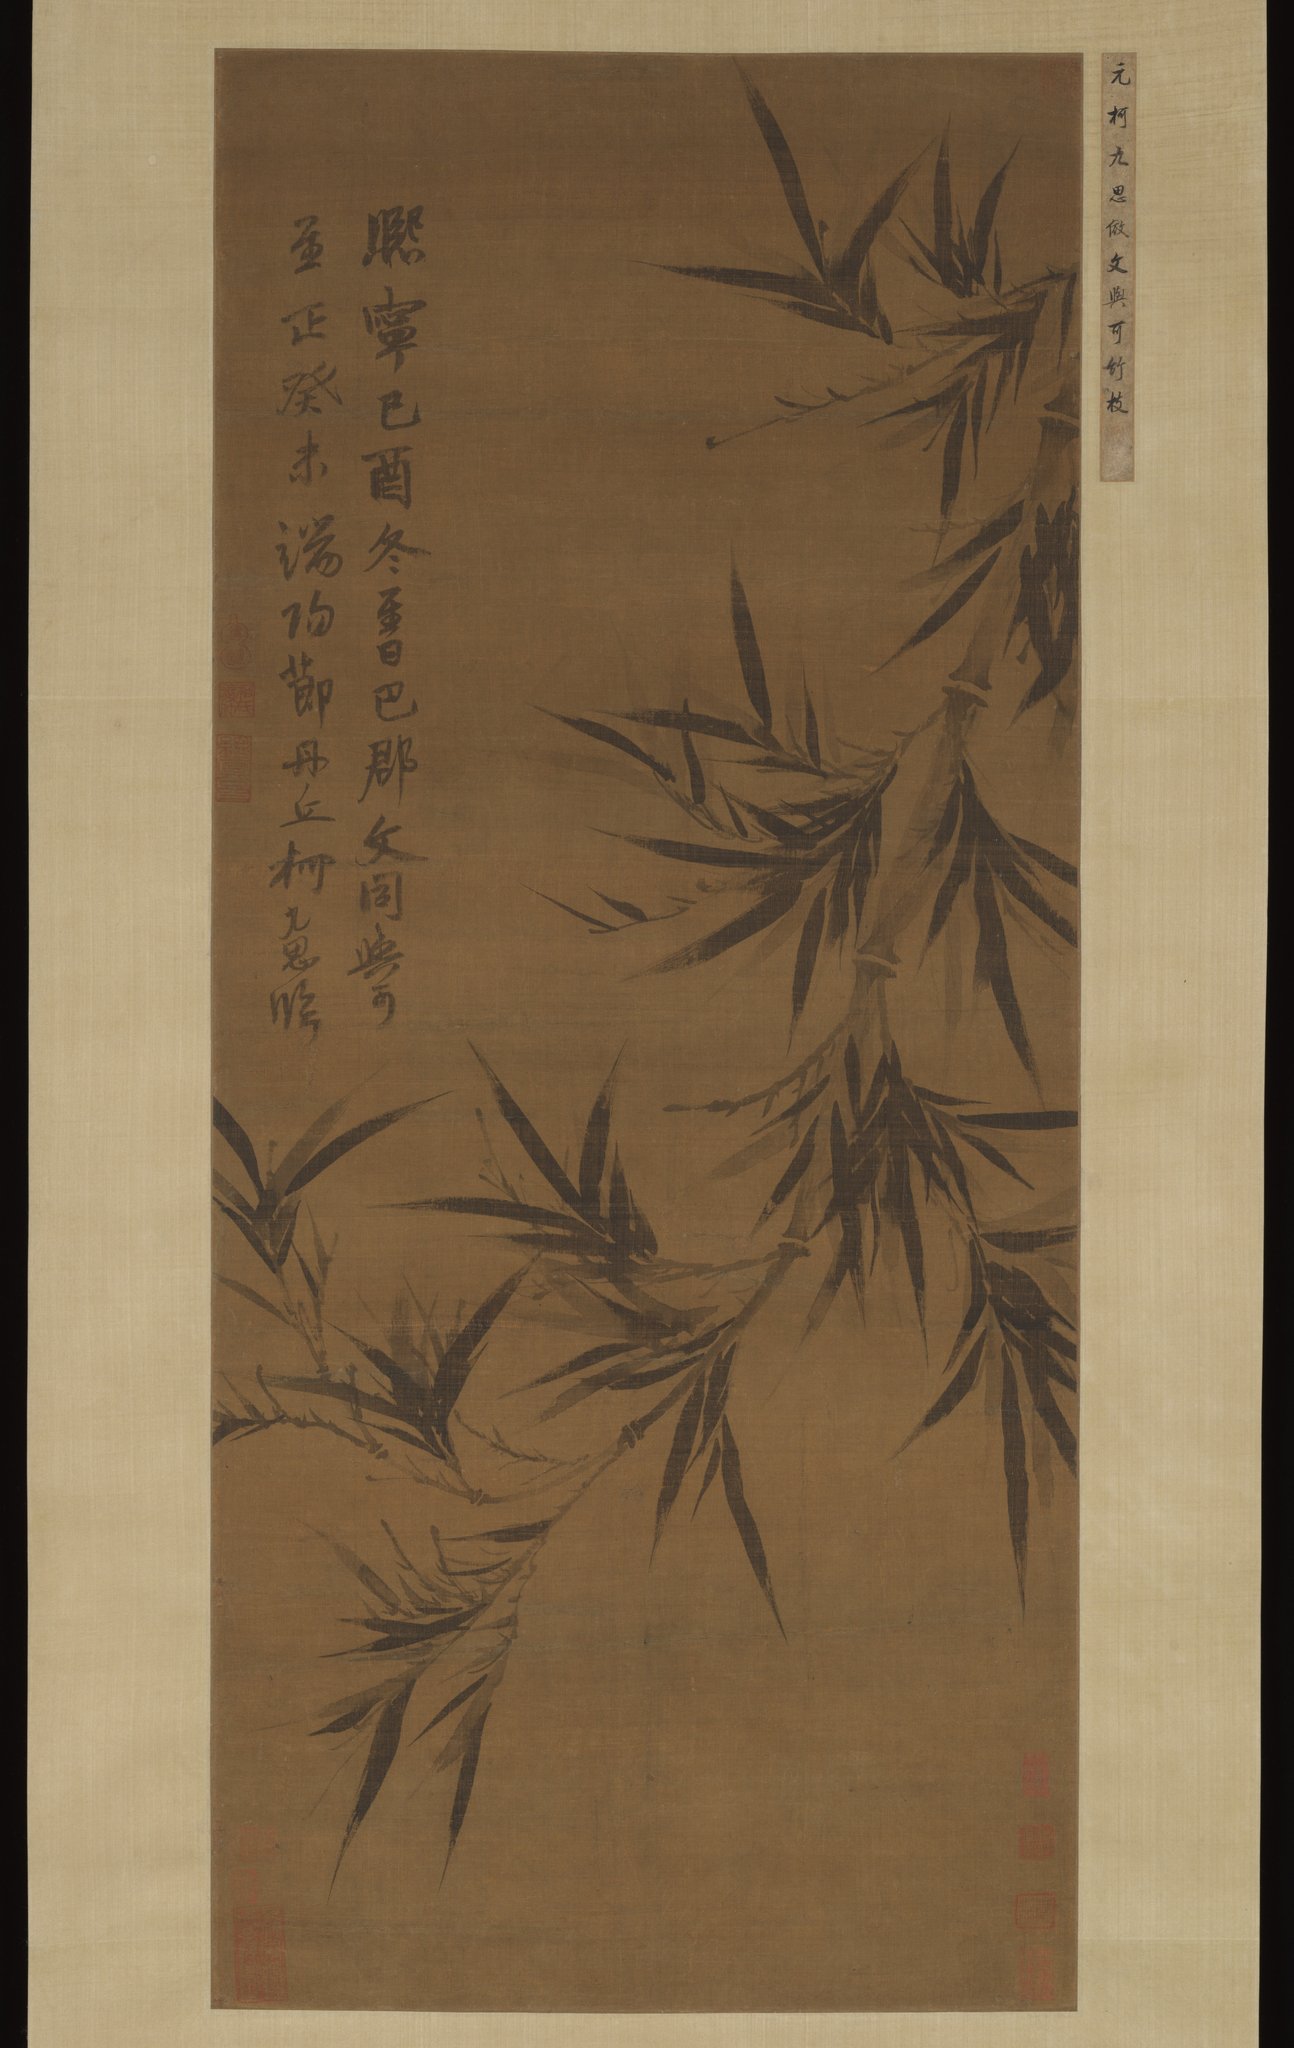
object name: hanging scroll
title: Bamboo copied after Wen Tong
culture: chinese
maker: ke jiusi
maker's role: artist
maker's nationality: chinese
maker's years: 1290-1343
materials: ink, silk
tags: bamboo